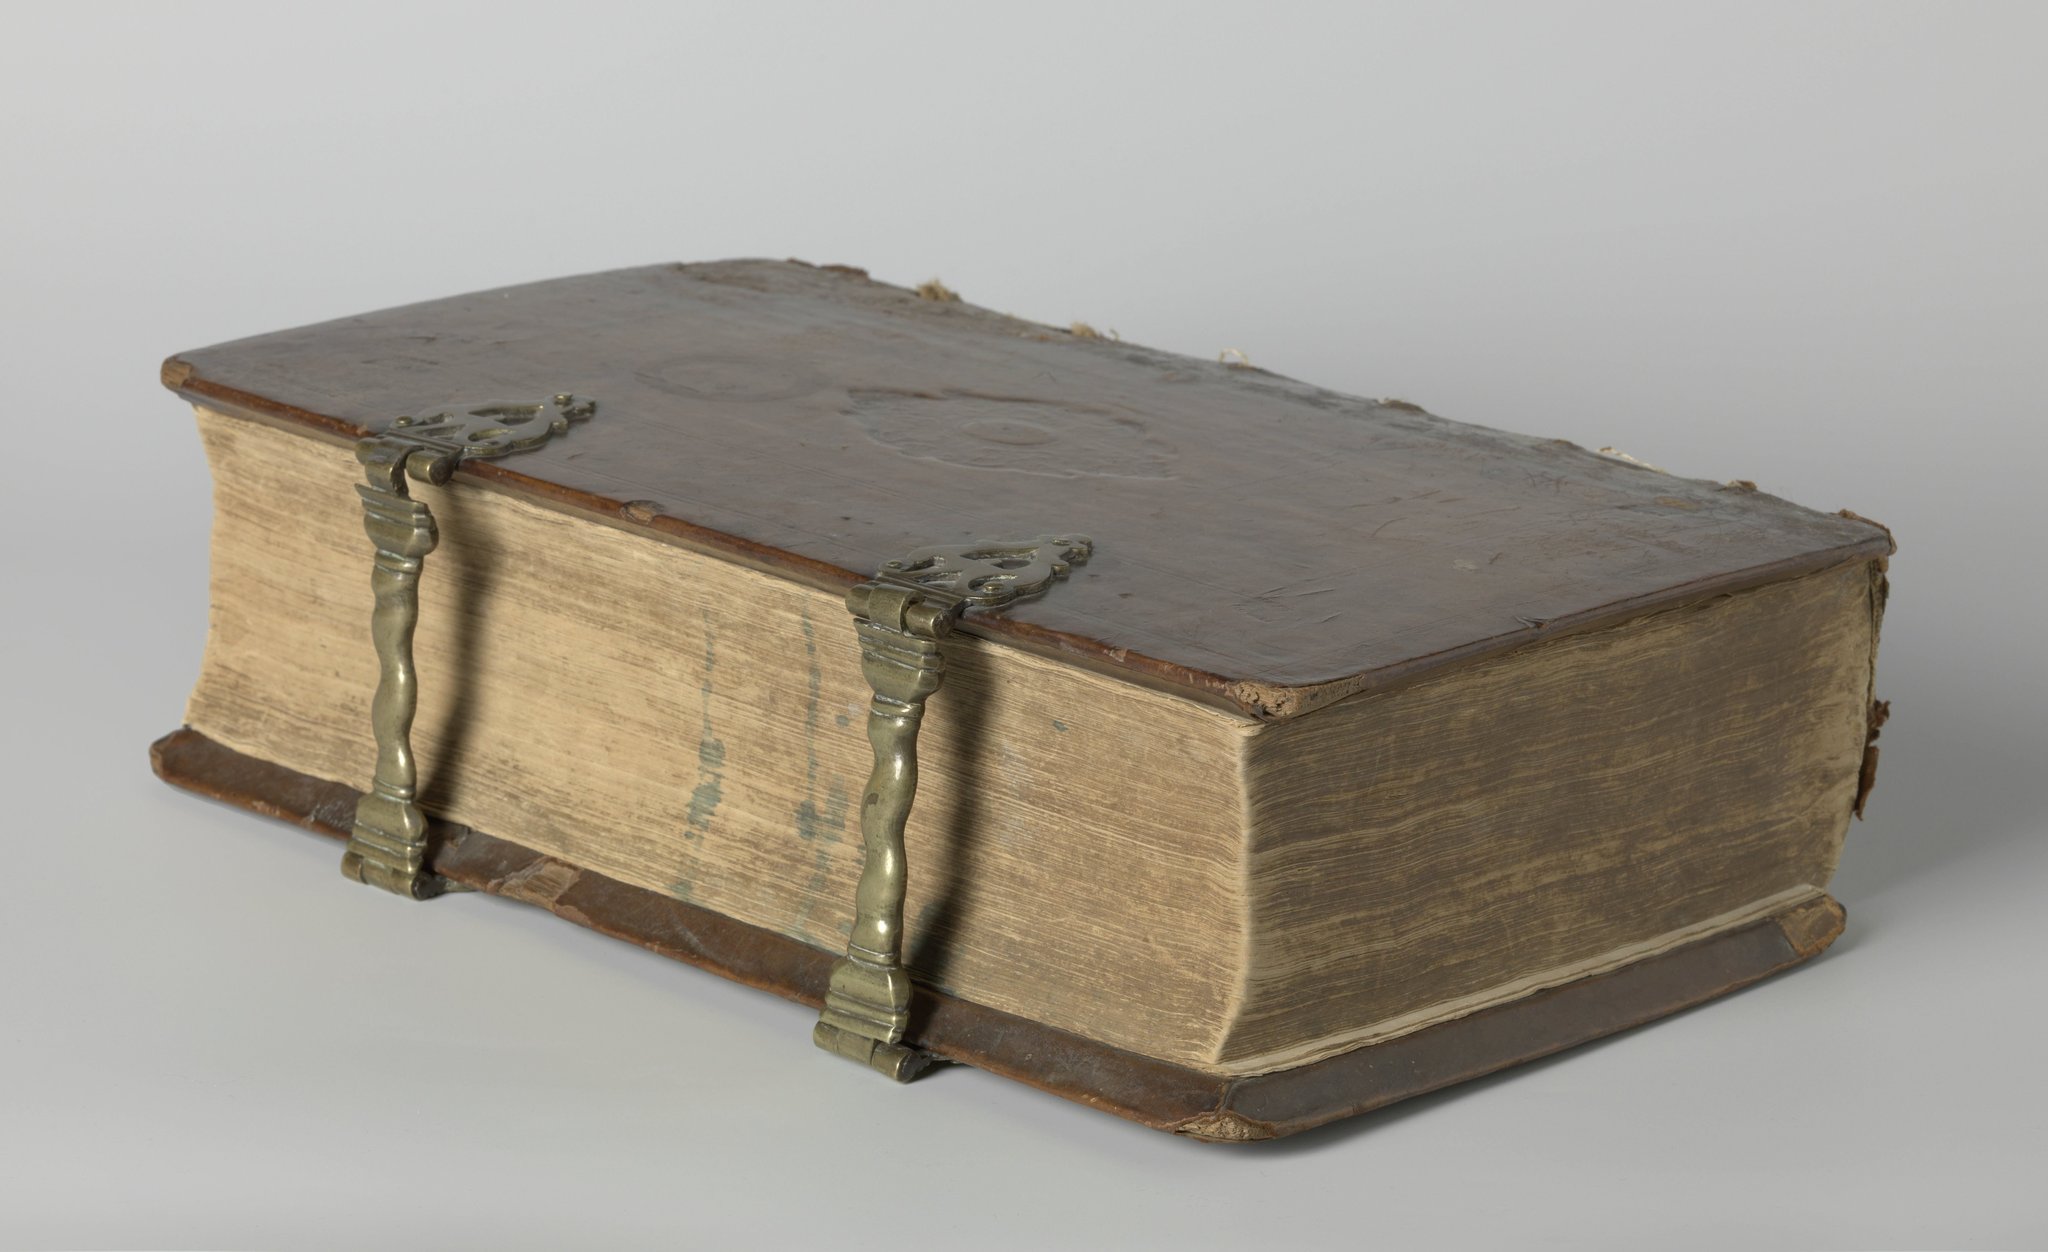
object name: bijbel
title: A Statenbijbel (States Bible)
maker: paulus aertsz. van ravesteyn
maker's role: publisher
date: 1637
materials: copper, leather, paper, fiber, wood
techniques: bookbinding, printing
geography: leiden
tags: brielle, maarten harpertszoon tromp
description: The Word of God – the Bible – is at the heart of the Dutch Reformed faith. In 1619 the States General, the Netherlands’ highest governing body, even commissions a new, ‘pure’ translation, which must be used in every church from then on. This explains why this Bible is called the ‘States Bible.’ The translation takes eighteen years. Every word is subject to lengthy debate. Changes are introduced up to the last moment, even in the opening lines. The translation is published only in 1637.